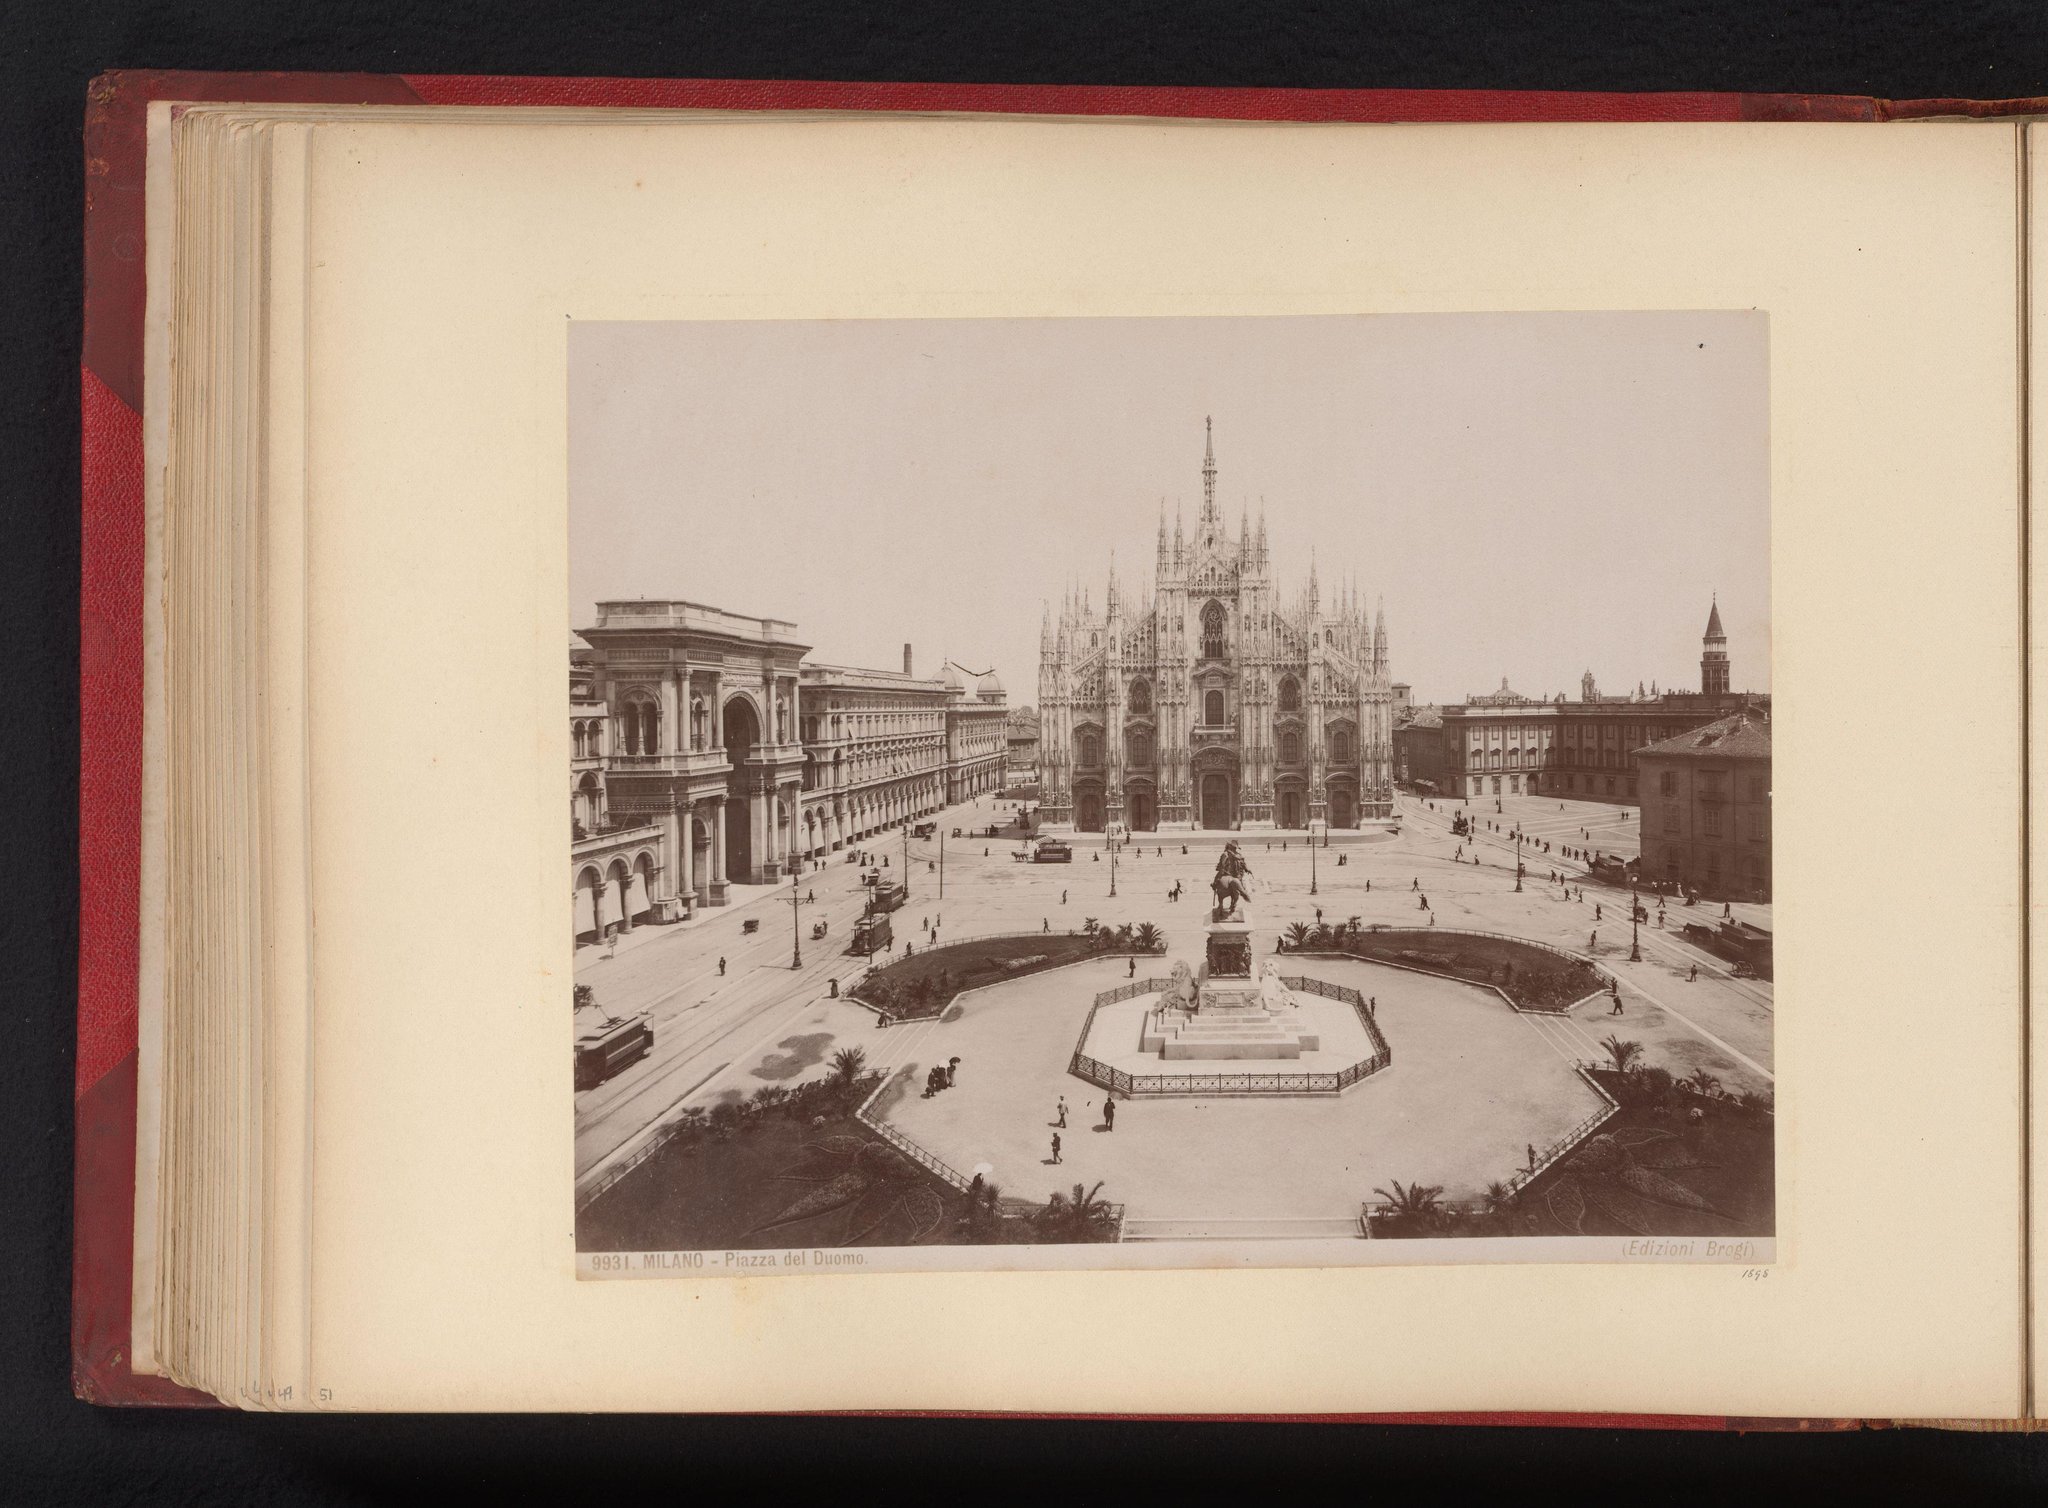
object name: album leaf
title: Gezicht op Piazza del Duomo met de Dom van Milaan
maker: Anonymous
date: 1898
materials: photographic support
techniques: albumen print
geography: milan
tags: church (exterior), square, place, circus, etc. (+ city(-scape) with figures, staffage)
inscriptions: inscription: ‘9931. Milano - Piazza del Duomo./ (Edizioni Brogi)’, annotation: ‘1898’